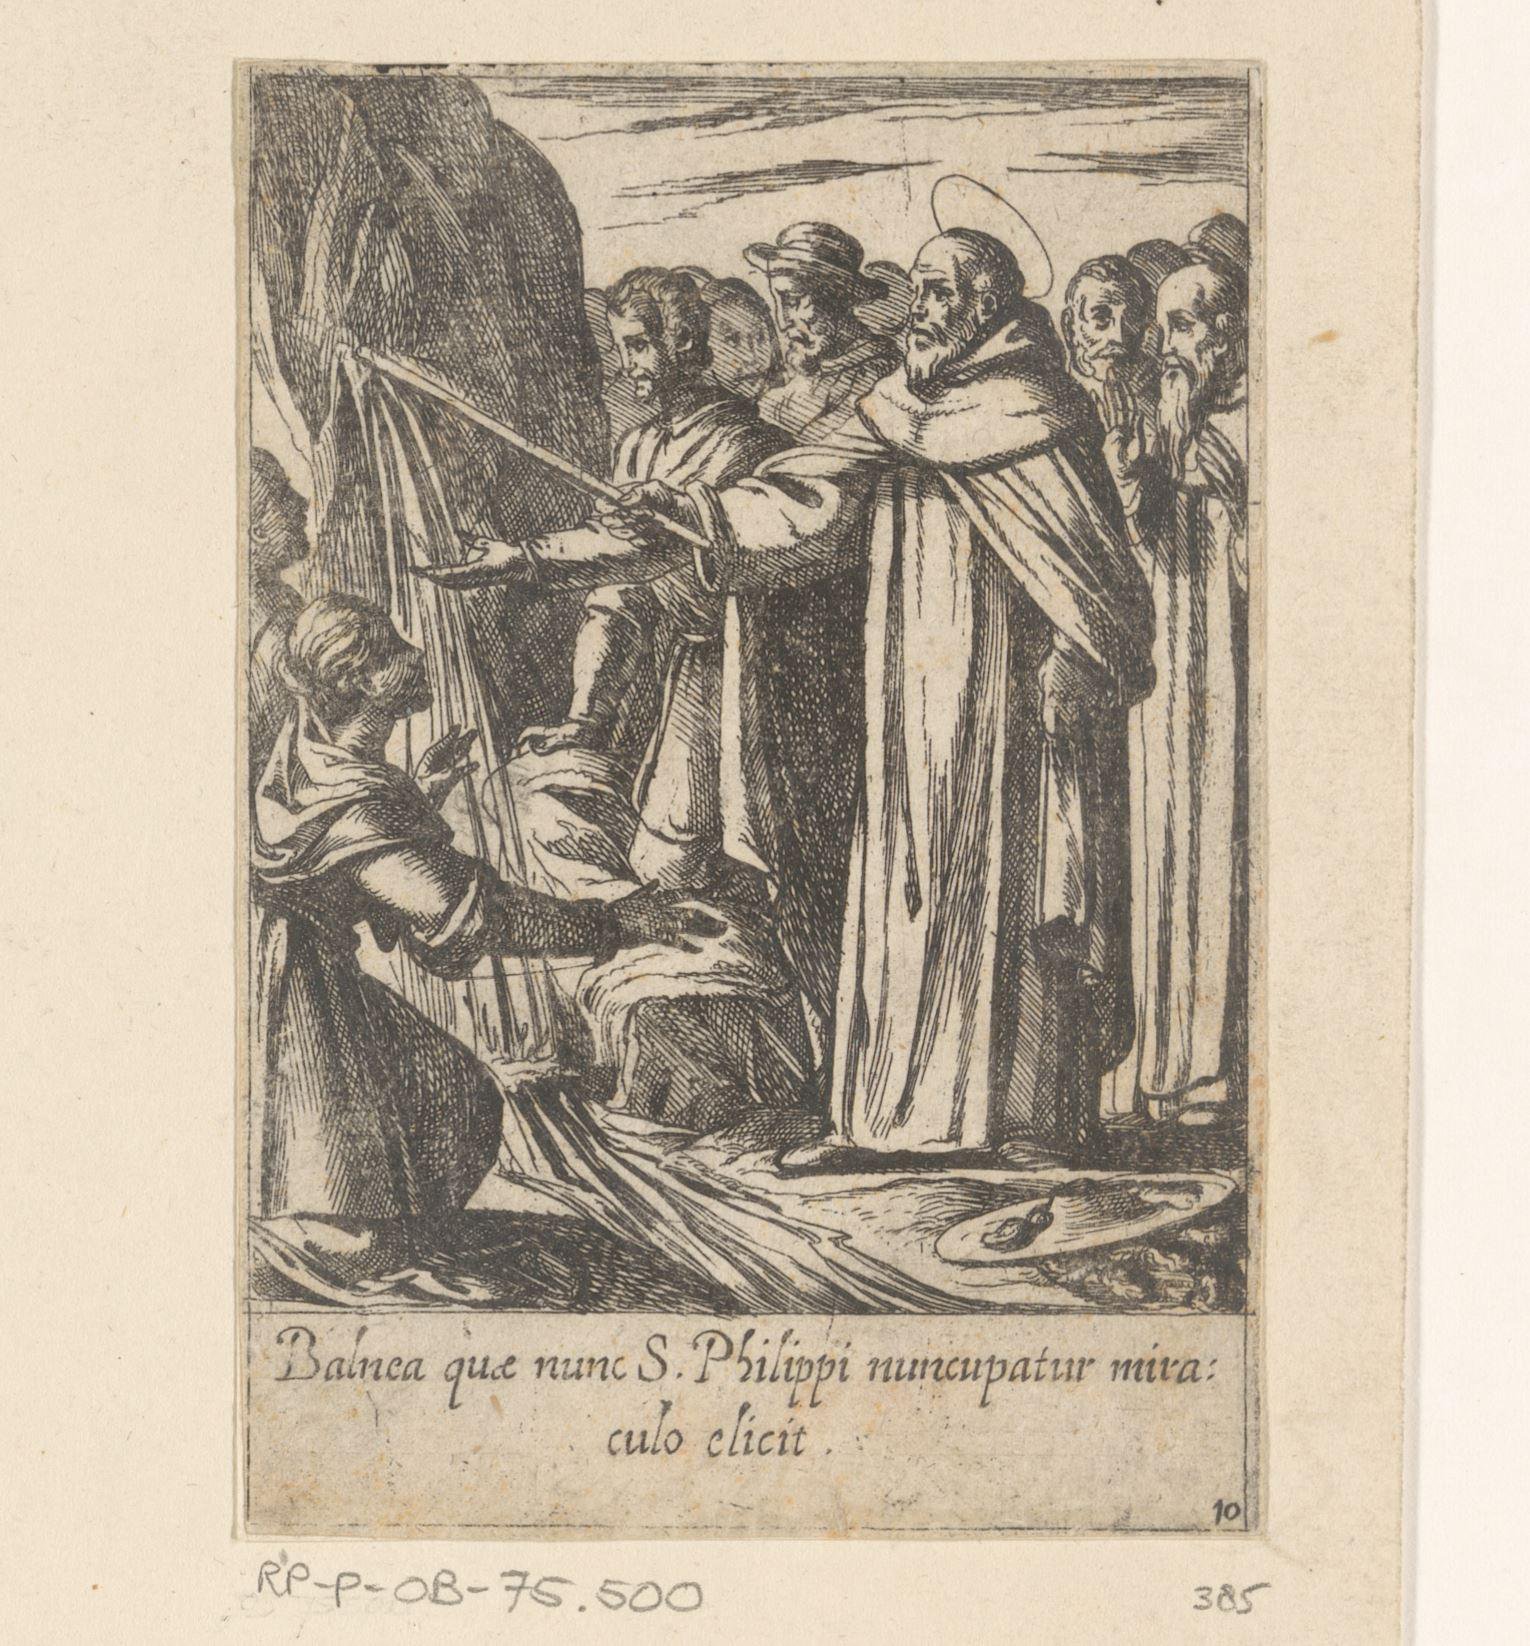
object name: print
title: Vita B. Philippi Benicii Florent. ord. servor B. Mariae virginis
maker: antonio tempesta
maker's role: draughtsman, painter, print maker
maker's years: 1555-1630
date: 1591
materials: paper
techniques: etching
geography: rome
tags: clergyman, prior general of the order of the servites, philip benizzi of florence; possible attributes: book, cross, lily, tiara at his feet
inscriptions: collector's mark: Lugt 240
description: De heilige Philippus verricht een wonder bij een miraculeuze bron. Een groep omstanders kijkt toe. Tekst in het Latijn in ondermarge. Genummerd rechtsonder: 10.